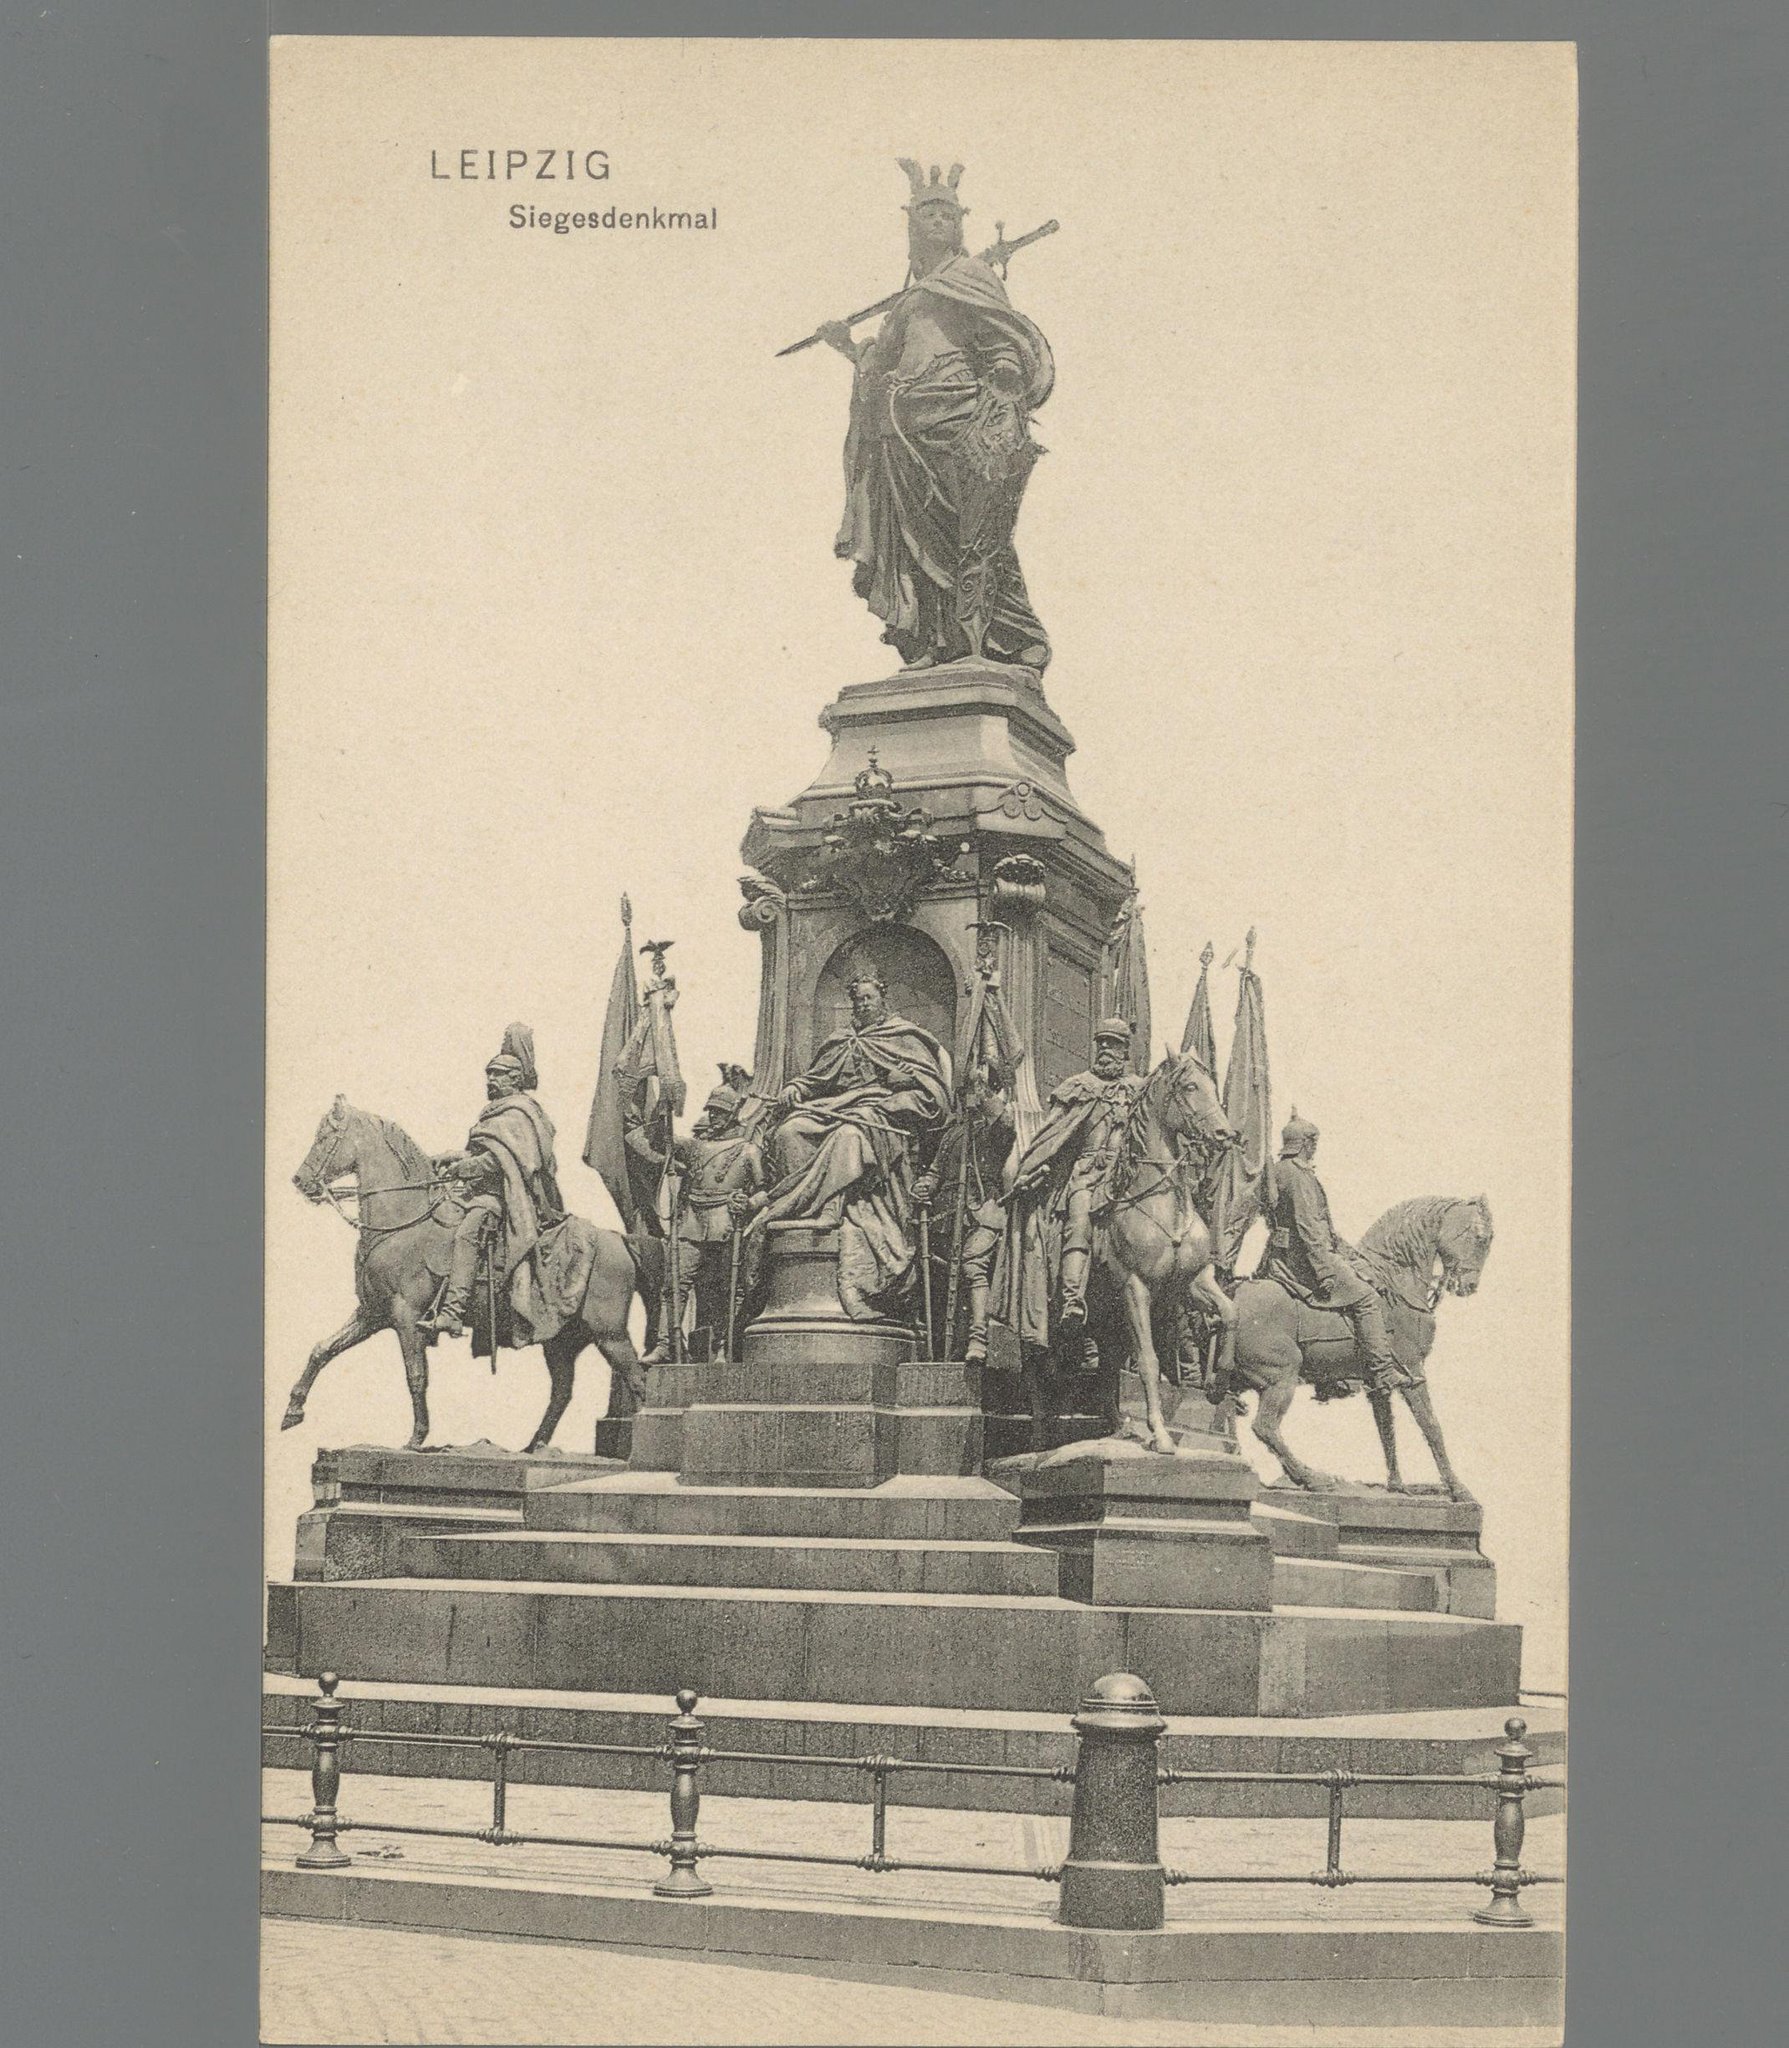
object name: ansichtkaart, prentbriefkaart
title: Leipzig. Siegesdenkmal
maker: Anonymous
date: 1907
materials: cardboard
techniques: photograph, writing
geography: leipzig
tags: monument, statue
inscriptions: date